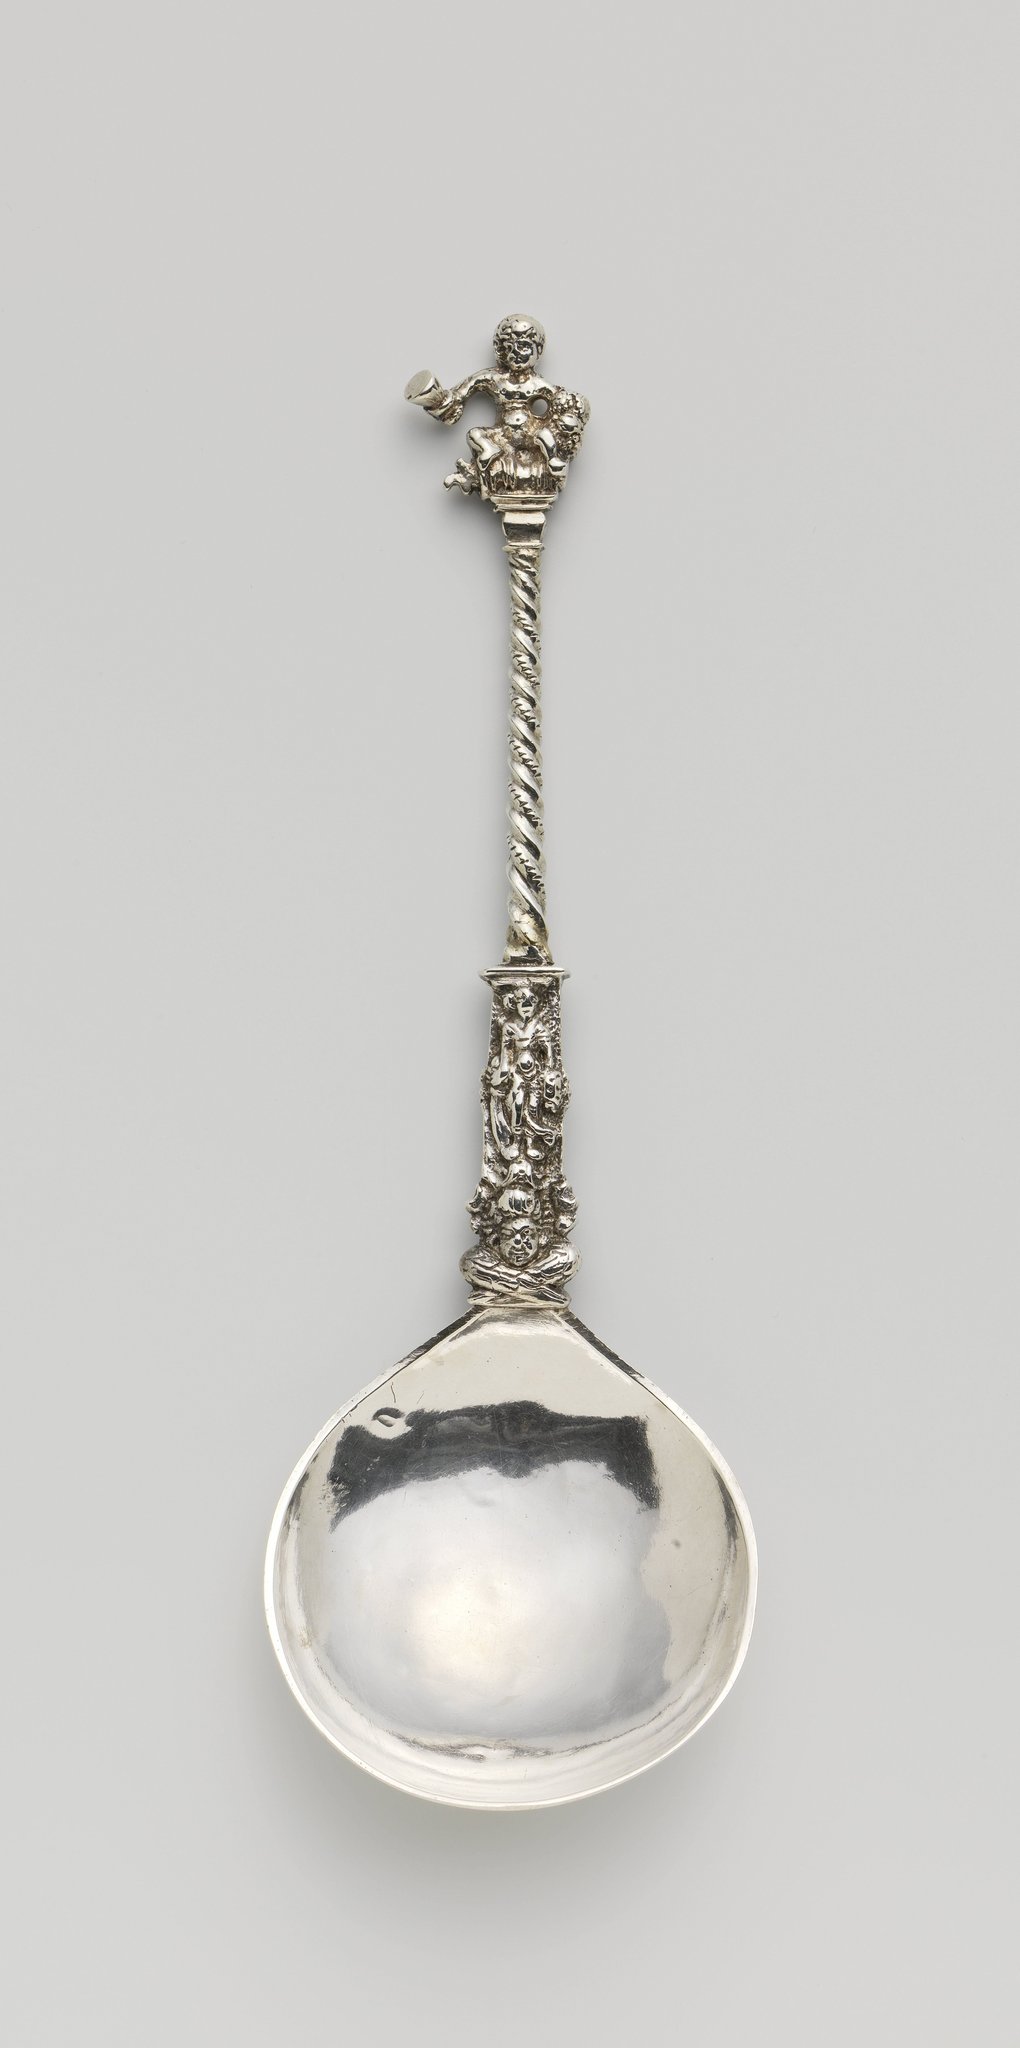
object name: commemorative spoon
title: Gedachtenislepel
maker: Anonymous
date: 1680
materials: silver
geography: enkhuizen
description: Gedachtenis-lepel van zilver, De ronde schep met puntig lof heeft een gegoten aanzetstuk met aan bijde zijden een figuur. Merk: Enkhuizen, (1680 of 1704) kleine leeuw en de jaarletter R, meesterteken PL. Bovenop de getorste steel, zit een naakte putto op een ton.